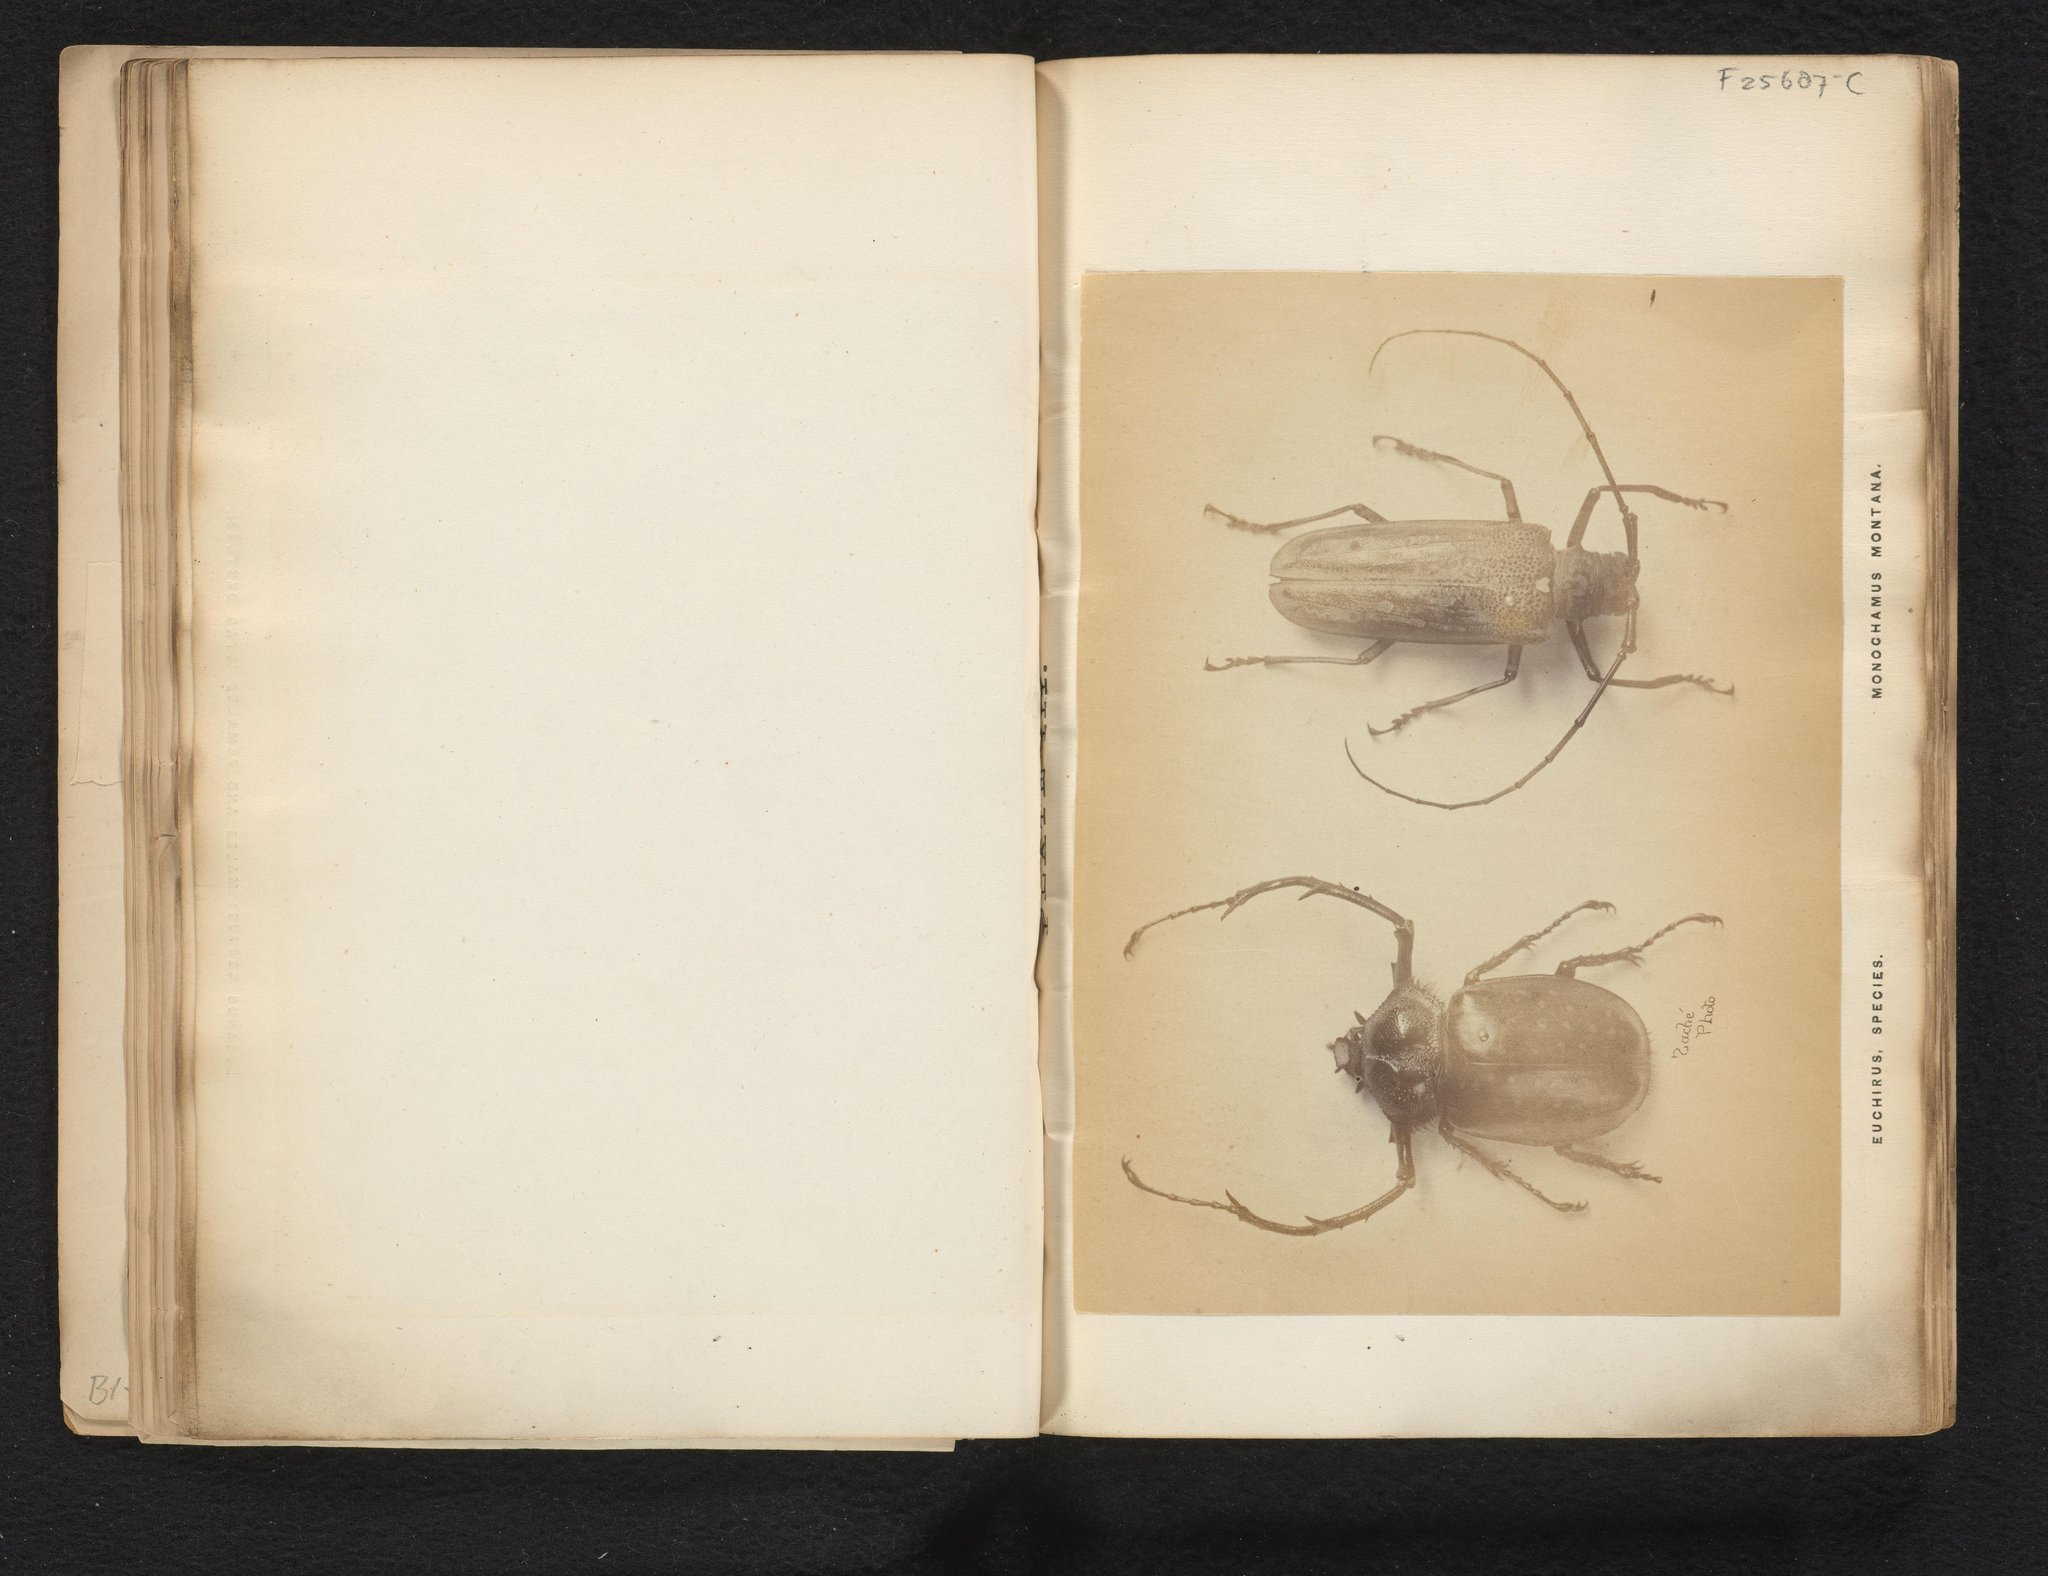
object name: photograph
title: Scarab beetle and longhorn beetle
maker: john edward saché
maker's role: fotograaf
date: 1863-1868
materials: paper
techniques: albumen print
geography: india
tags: insects: beetle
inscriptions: inscription: ‘PLATE III.’, inscription: ‘EUCHIRUS, SPECIES. MONOCHAMUS MONTANA.’, inscription: ‘Saché Photo’